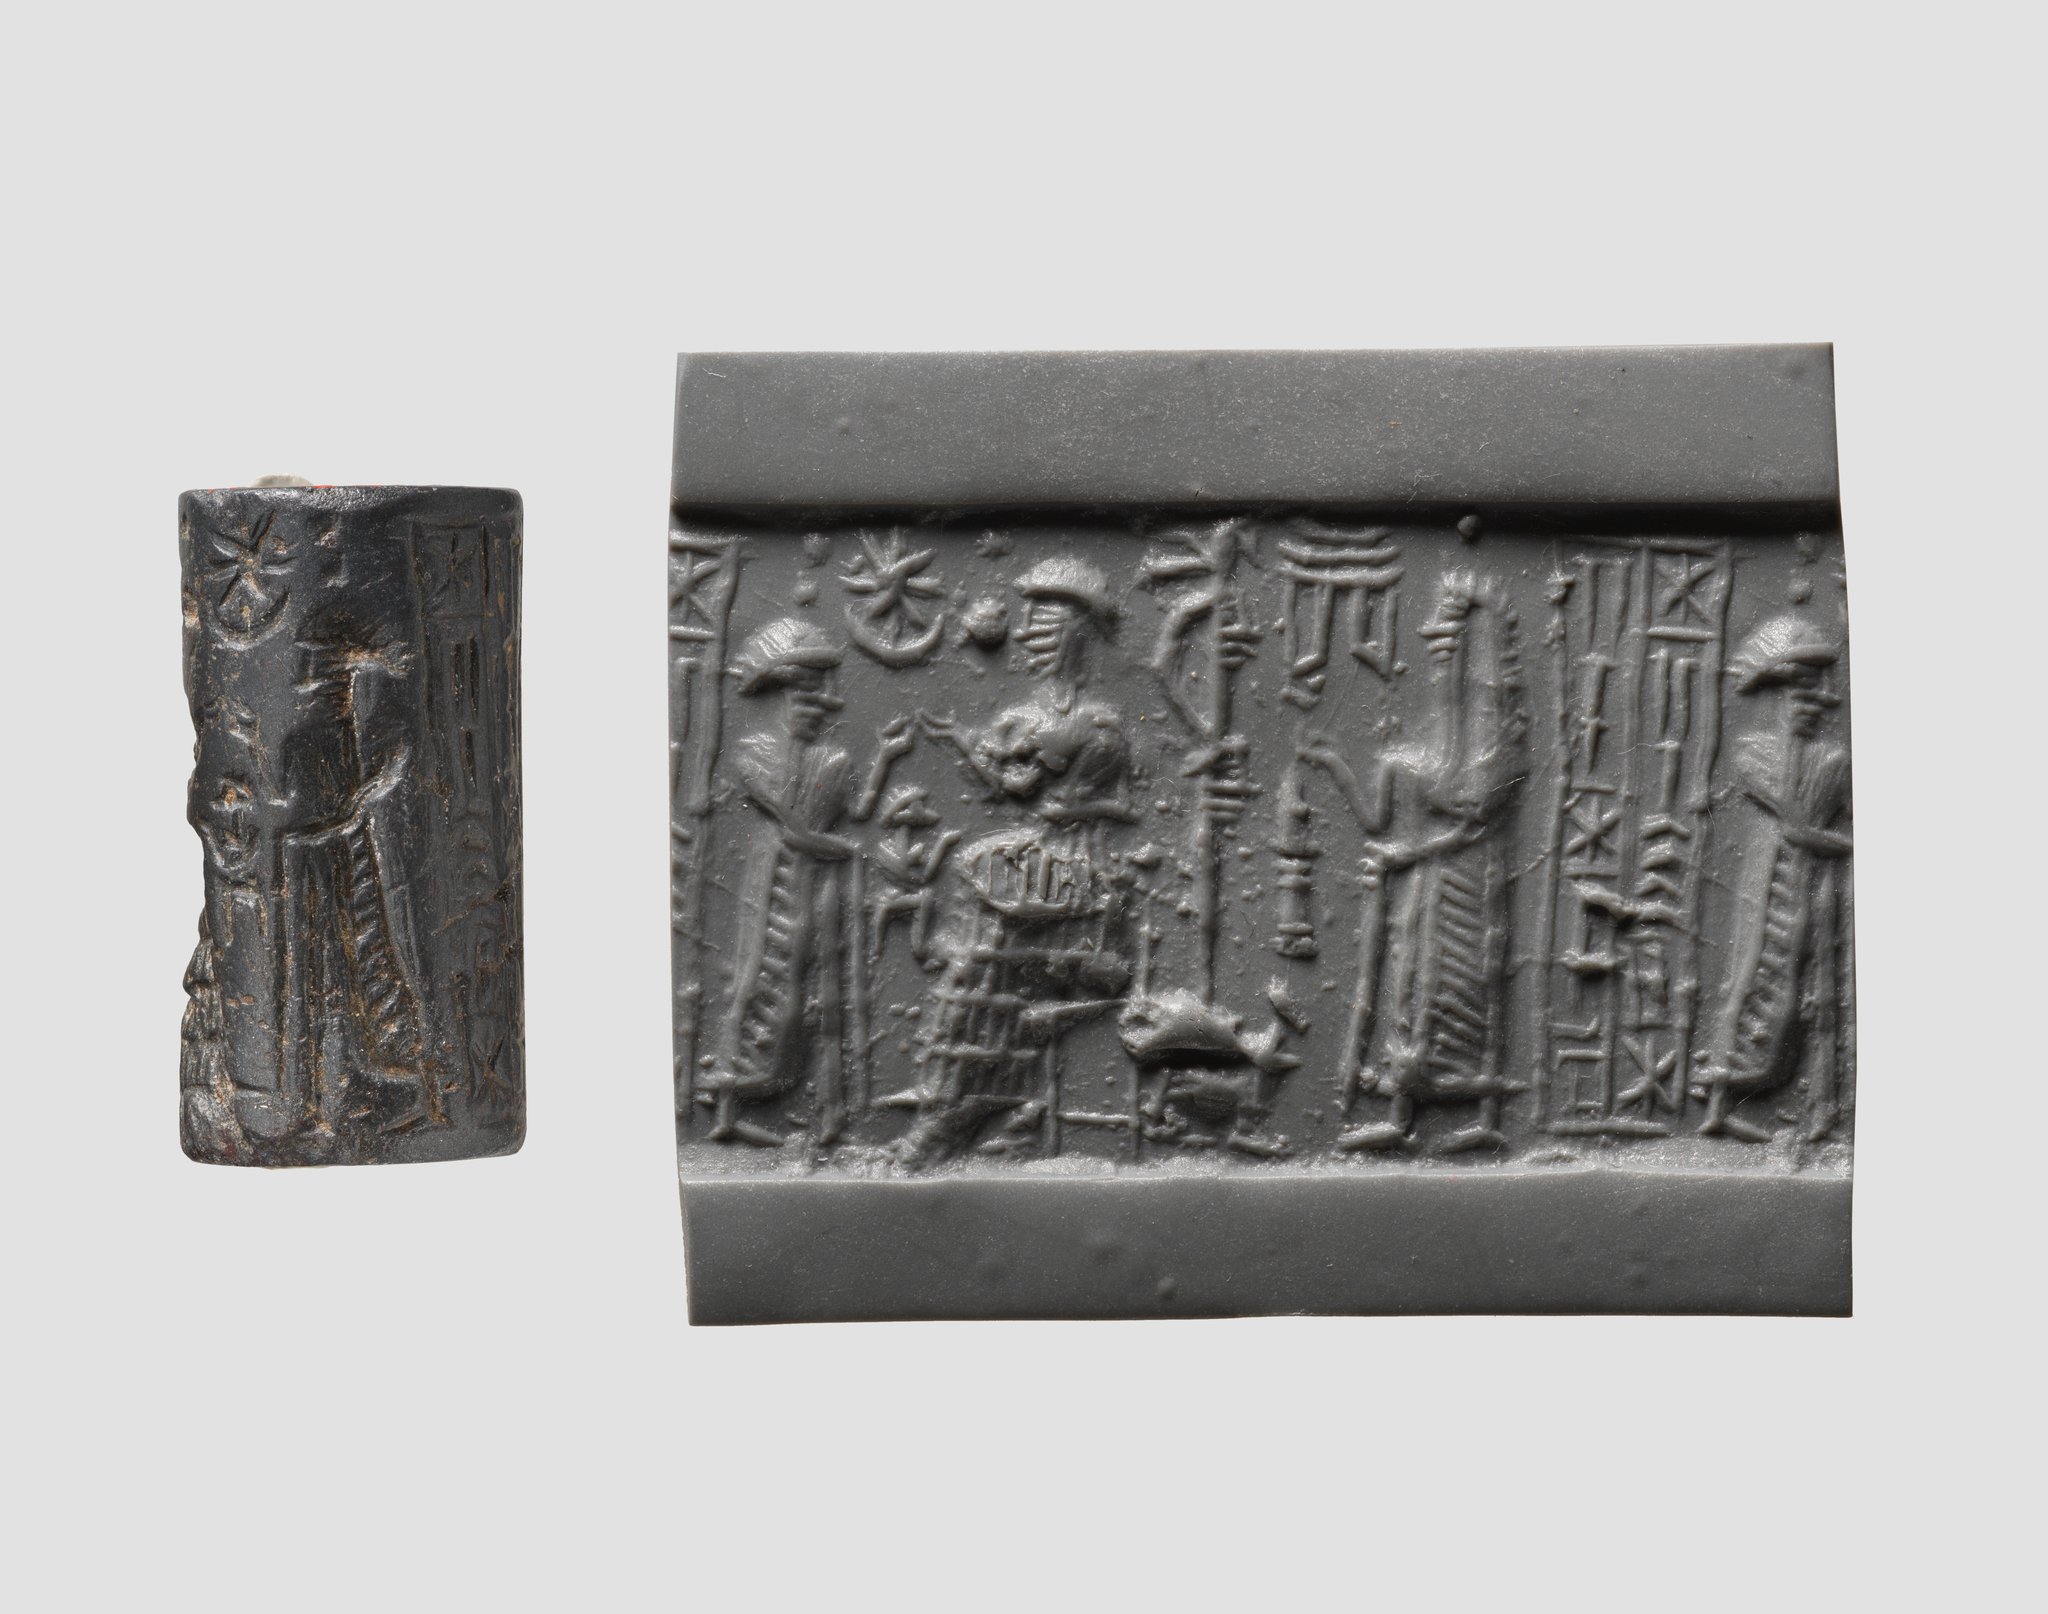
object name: cylinder seal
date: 1820-1730 BCE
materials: mineral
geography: syria